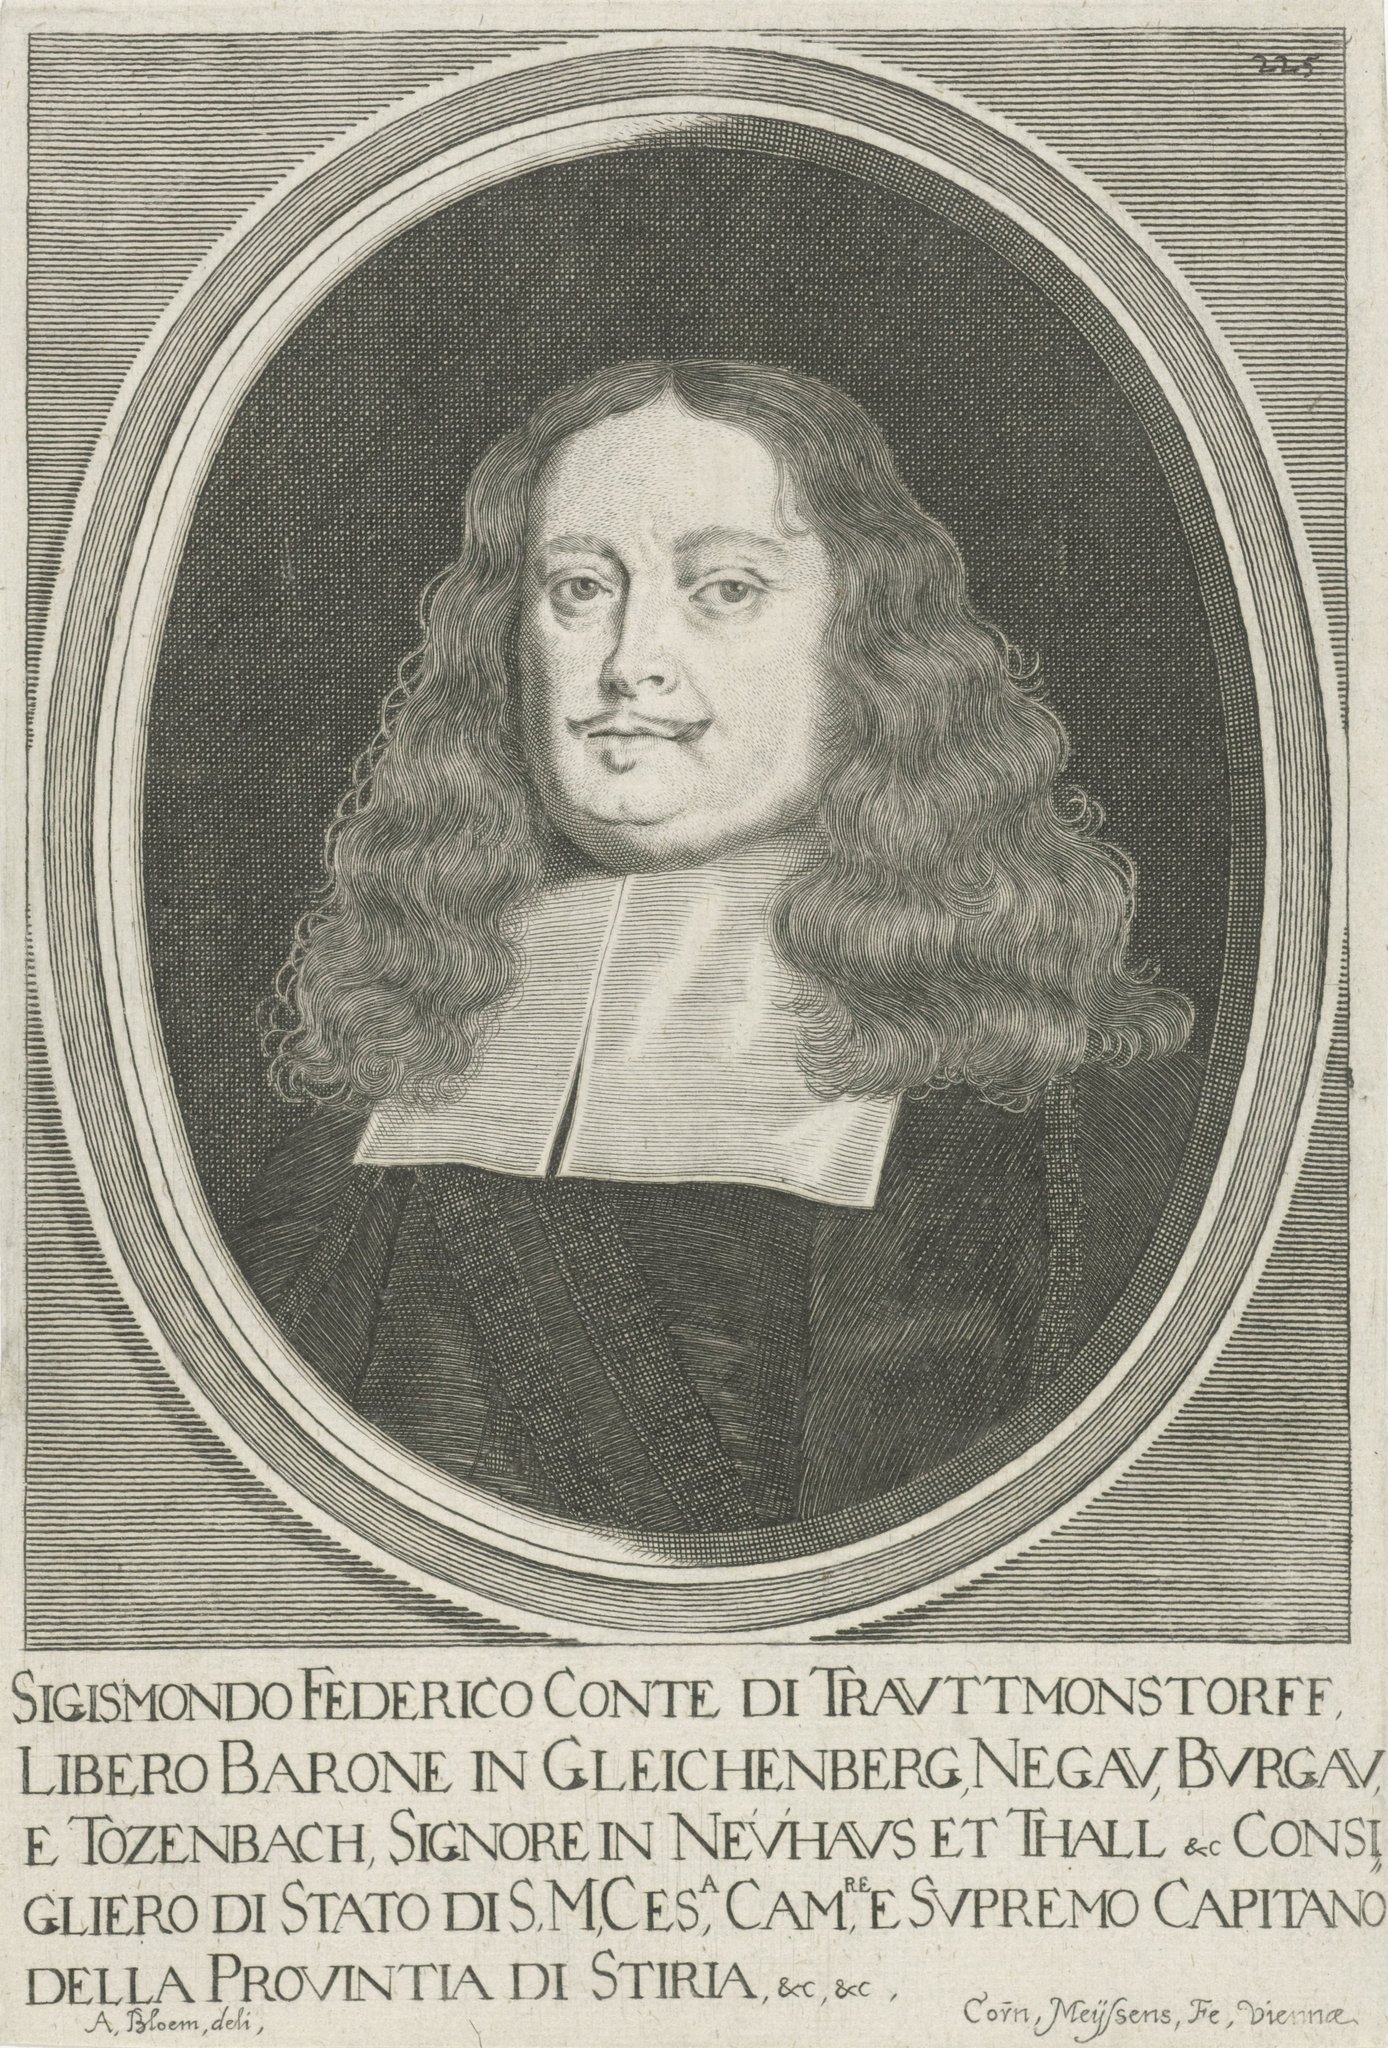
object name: print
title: Portret van Sigmund Friedrich graaf van Trauttmansdorff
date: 1670-1674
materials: paper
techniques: engraving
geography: vienna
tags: graz, raadsheer, penningmeester, siegmund friedrich von trauttmansdorff (graaf)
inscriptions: collector's mark: Lugt 2228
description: Portret van Sigmund Friedrich graaf van Trauttmansdorff. Onderaan in de marge zijn titel en functie in het Italiaans. Rechtsboven genummerd: 225.